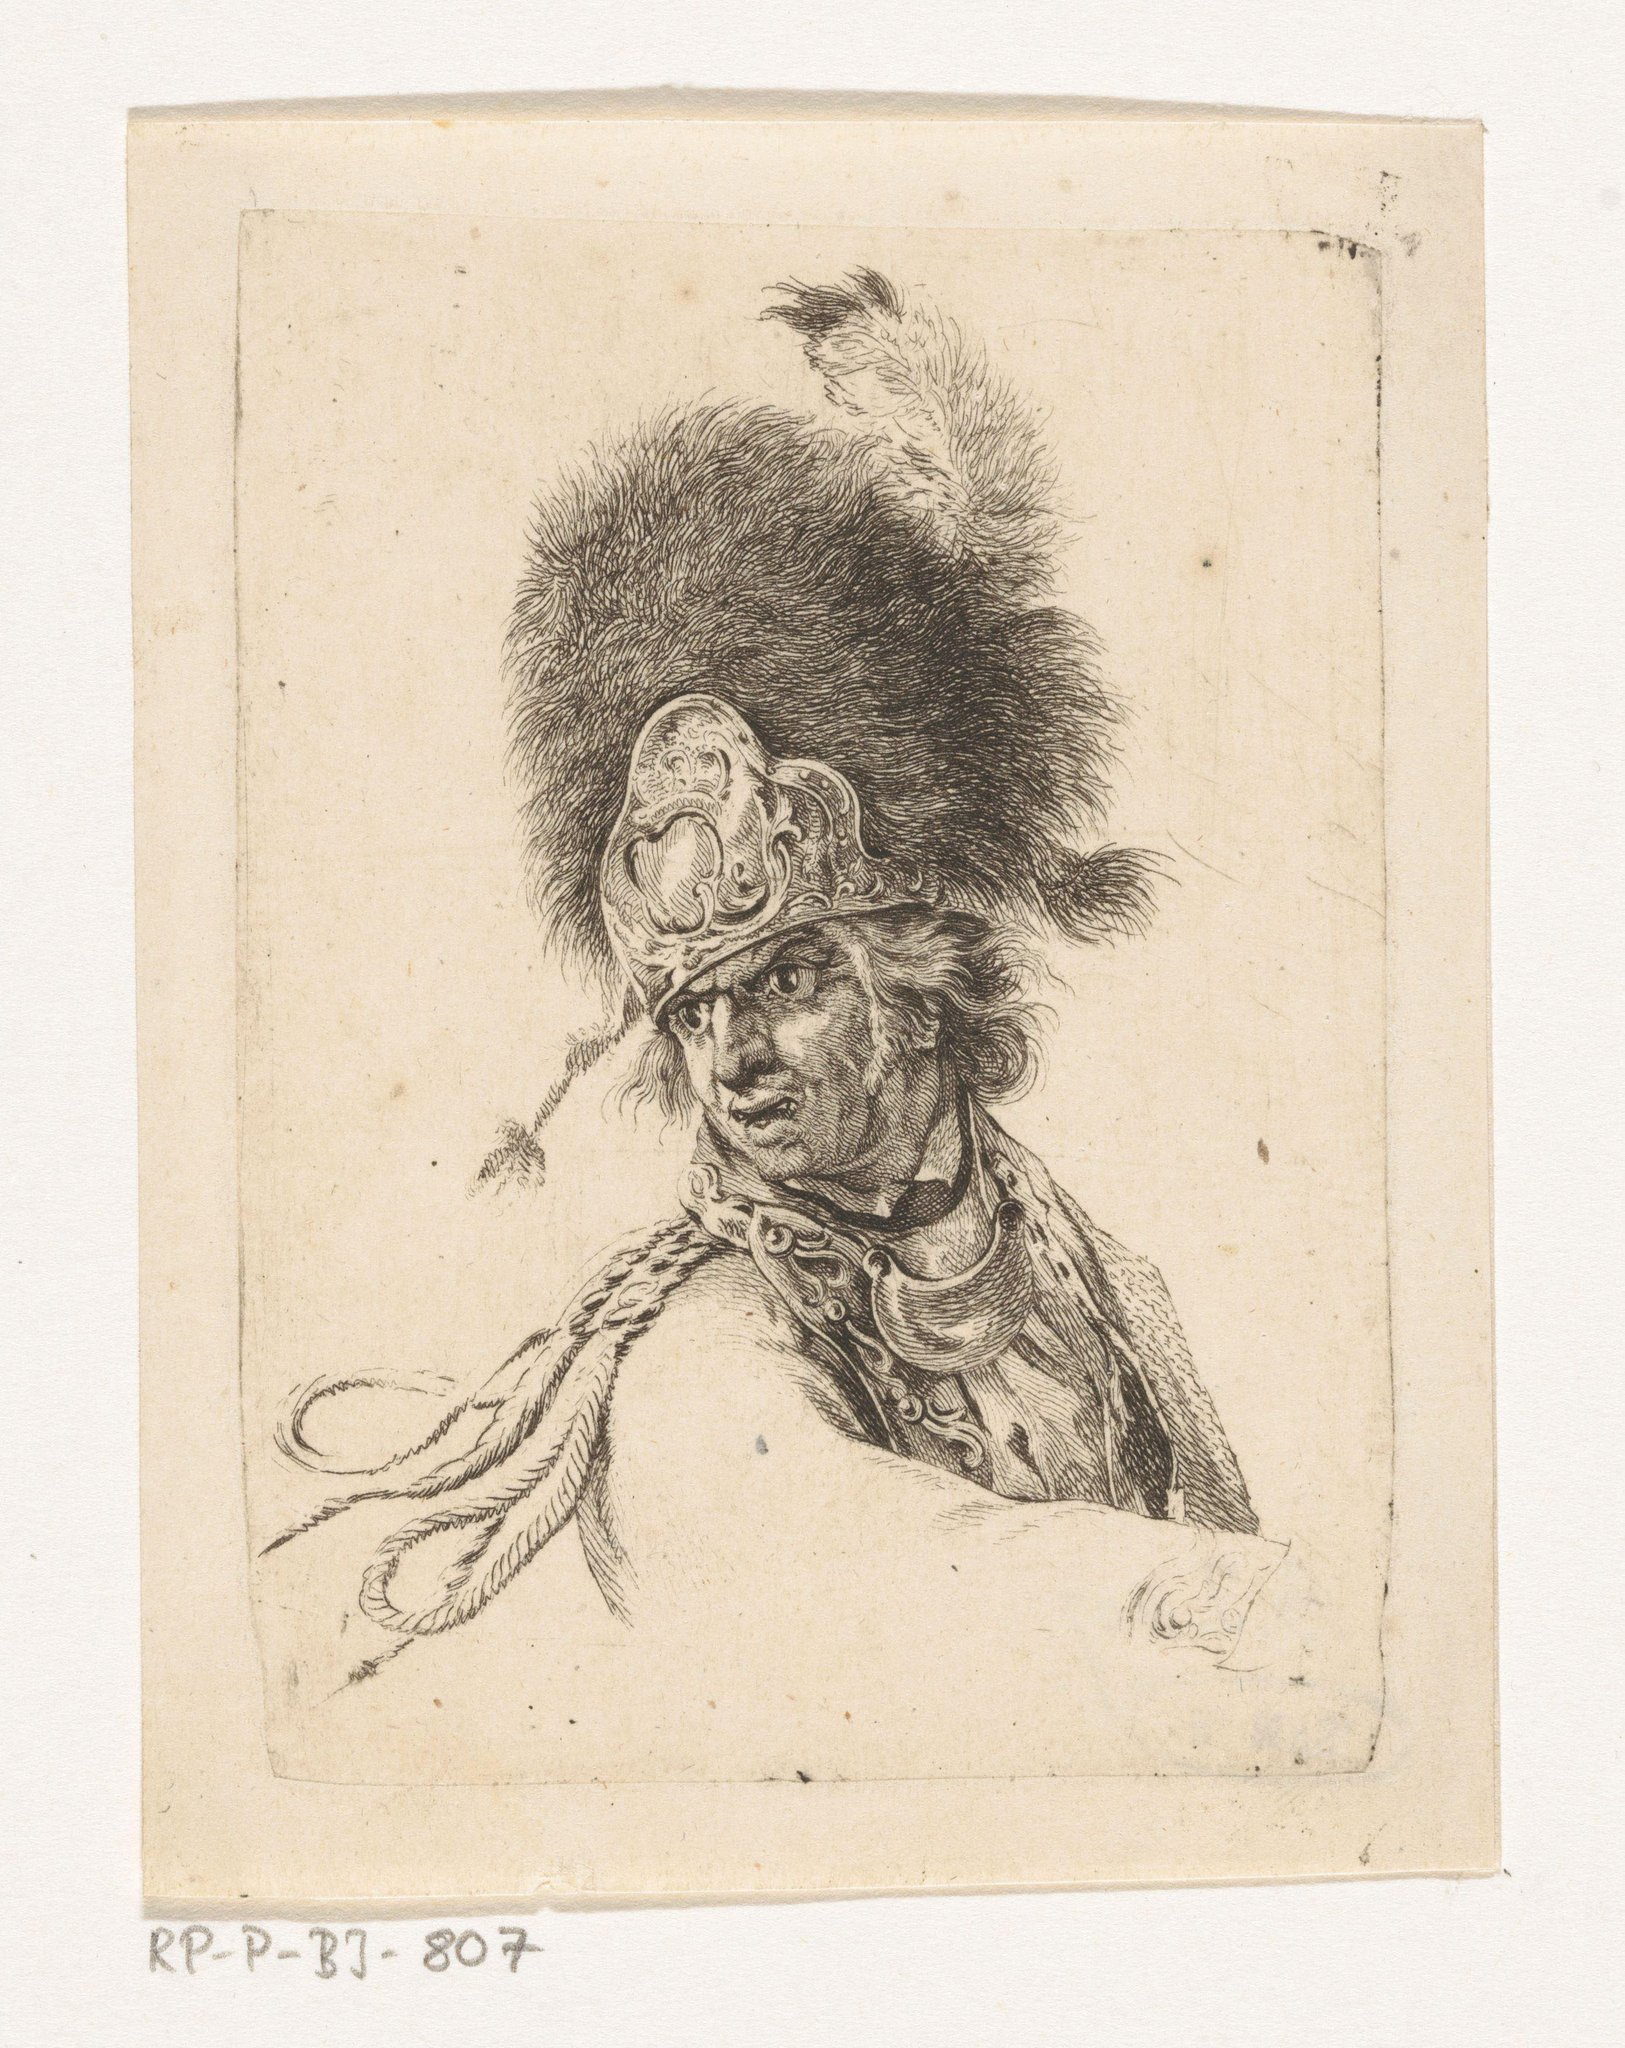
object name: print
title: Portret van een soldaat met een hoge bontmuts op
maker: joannes bemme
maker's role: print maker, printer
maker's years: 1775-1841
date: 1800-1841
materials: paper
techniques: etching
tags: head-gear: cap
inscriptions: collector's mark: Lugt 2228